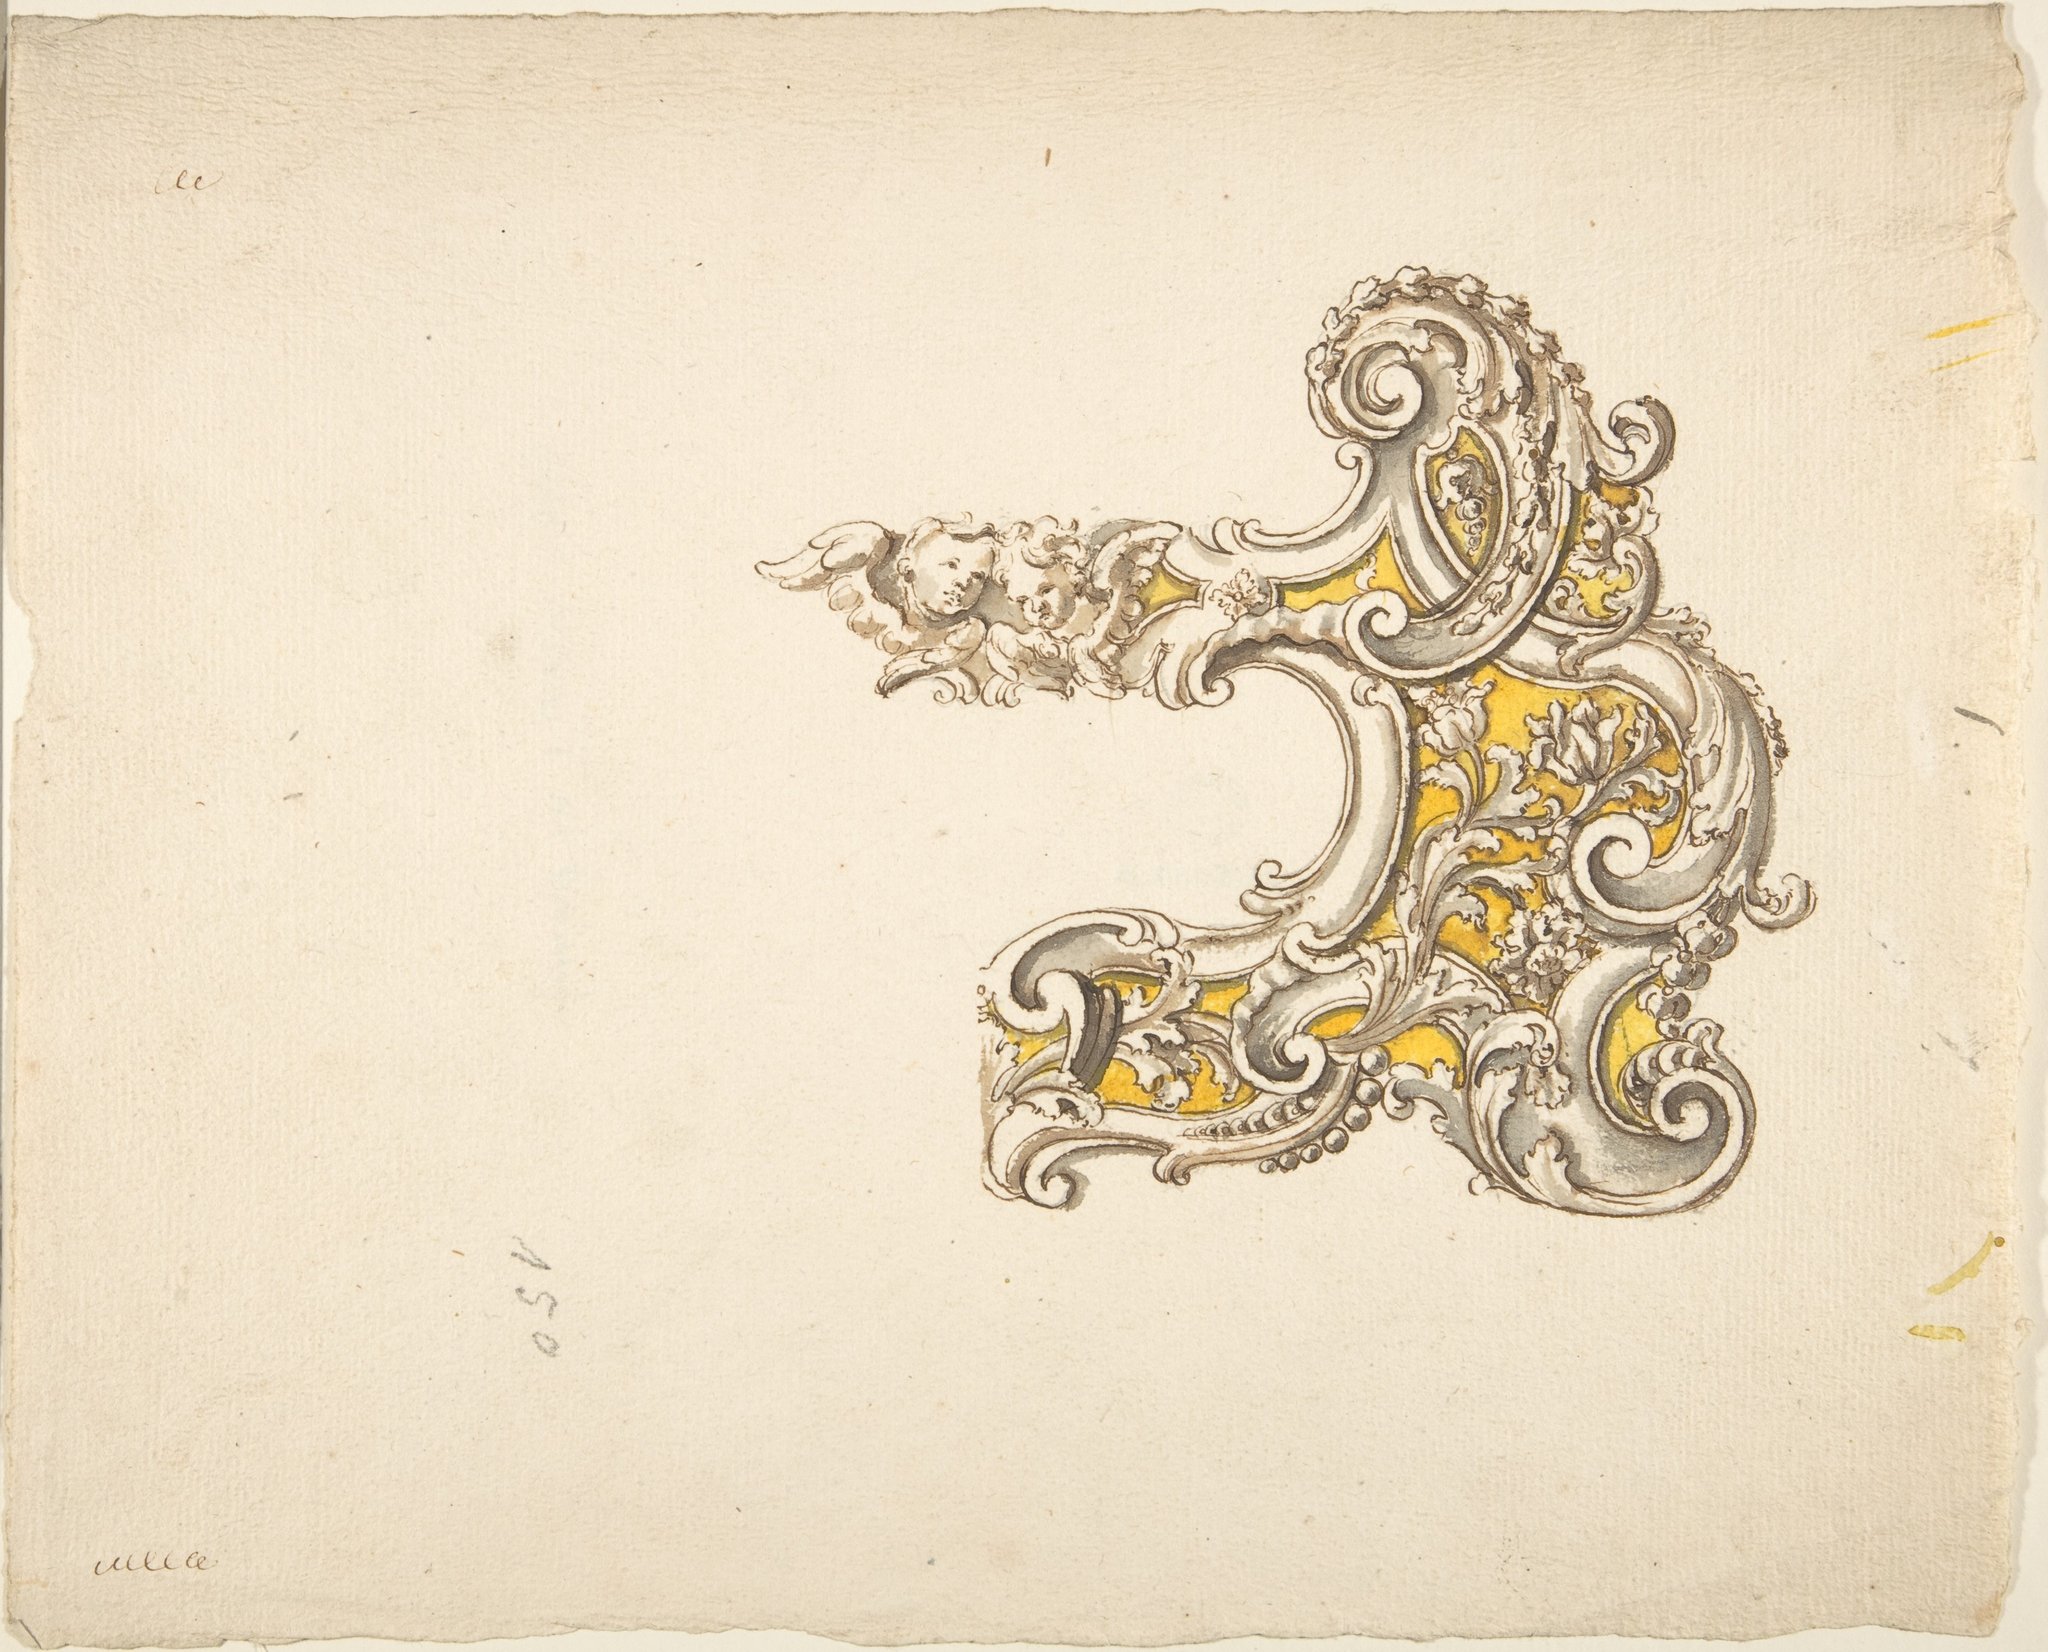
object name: drawing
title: Half Rococo Cartouche with Cherubs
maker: anonymous, italian, 18th century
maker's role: artist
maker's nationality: italian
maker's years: 1700-1800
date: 1701-1800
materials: ink, watercolor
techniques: pen, wash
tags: cartouches